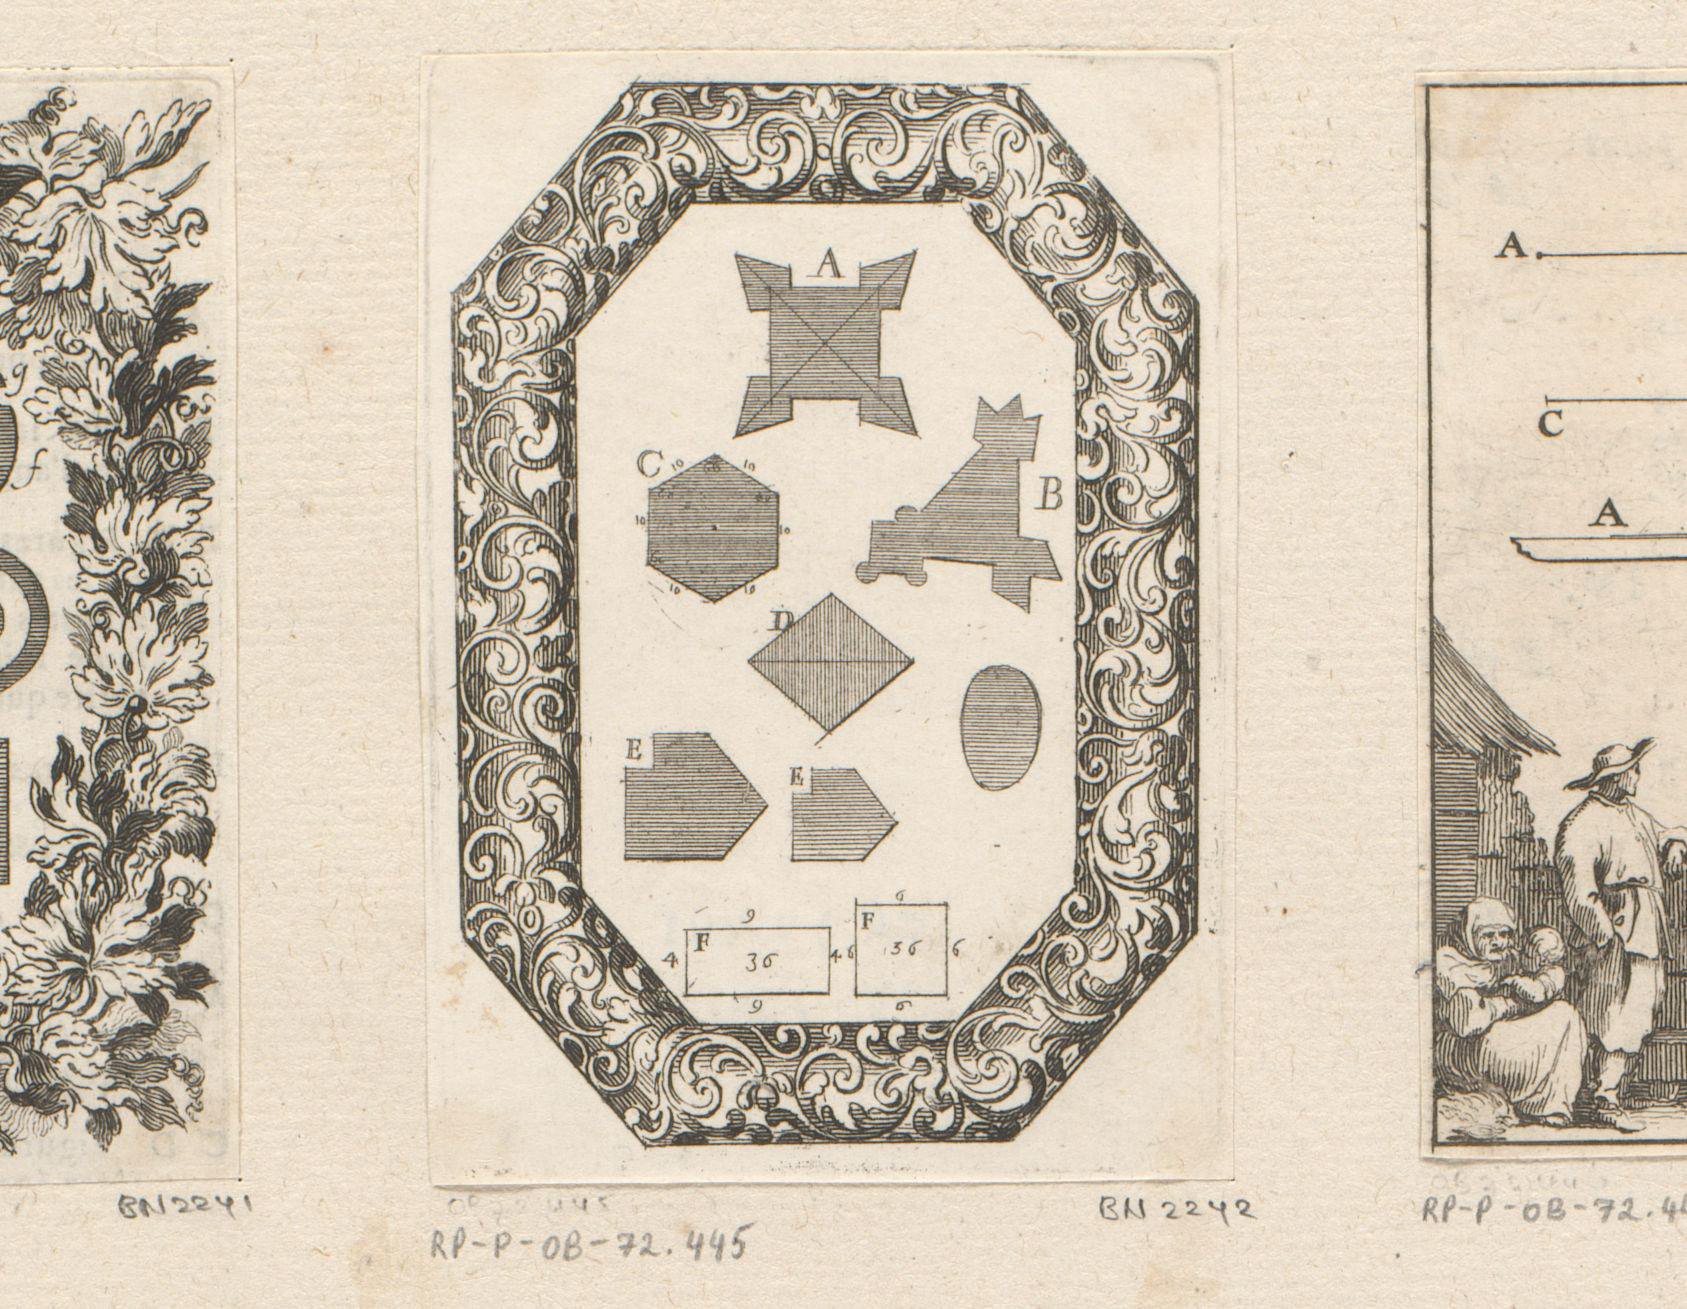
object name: print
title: Regelmatige en onregelmatige figuren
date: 1669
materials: paper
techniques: etching, letterpress printing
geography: paris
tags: planimetry, geometry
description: Prent uit: Pratique de la géometrie, sur le papier et sur le terrain. Avec un nouvel ordre et une méthode particulière. Parijs: Thomas Jolly, 1669.